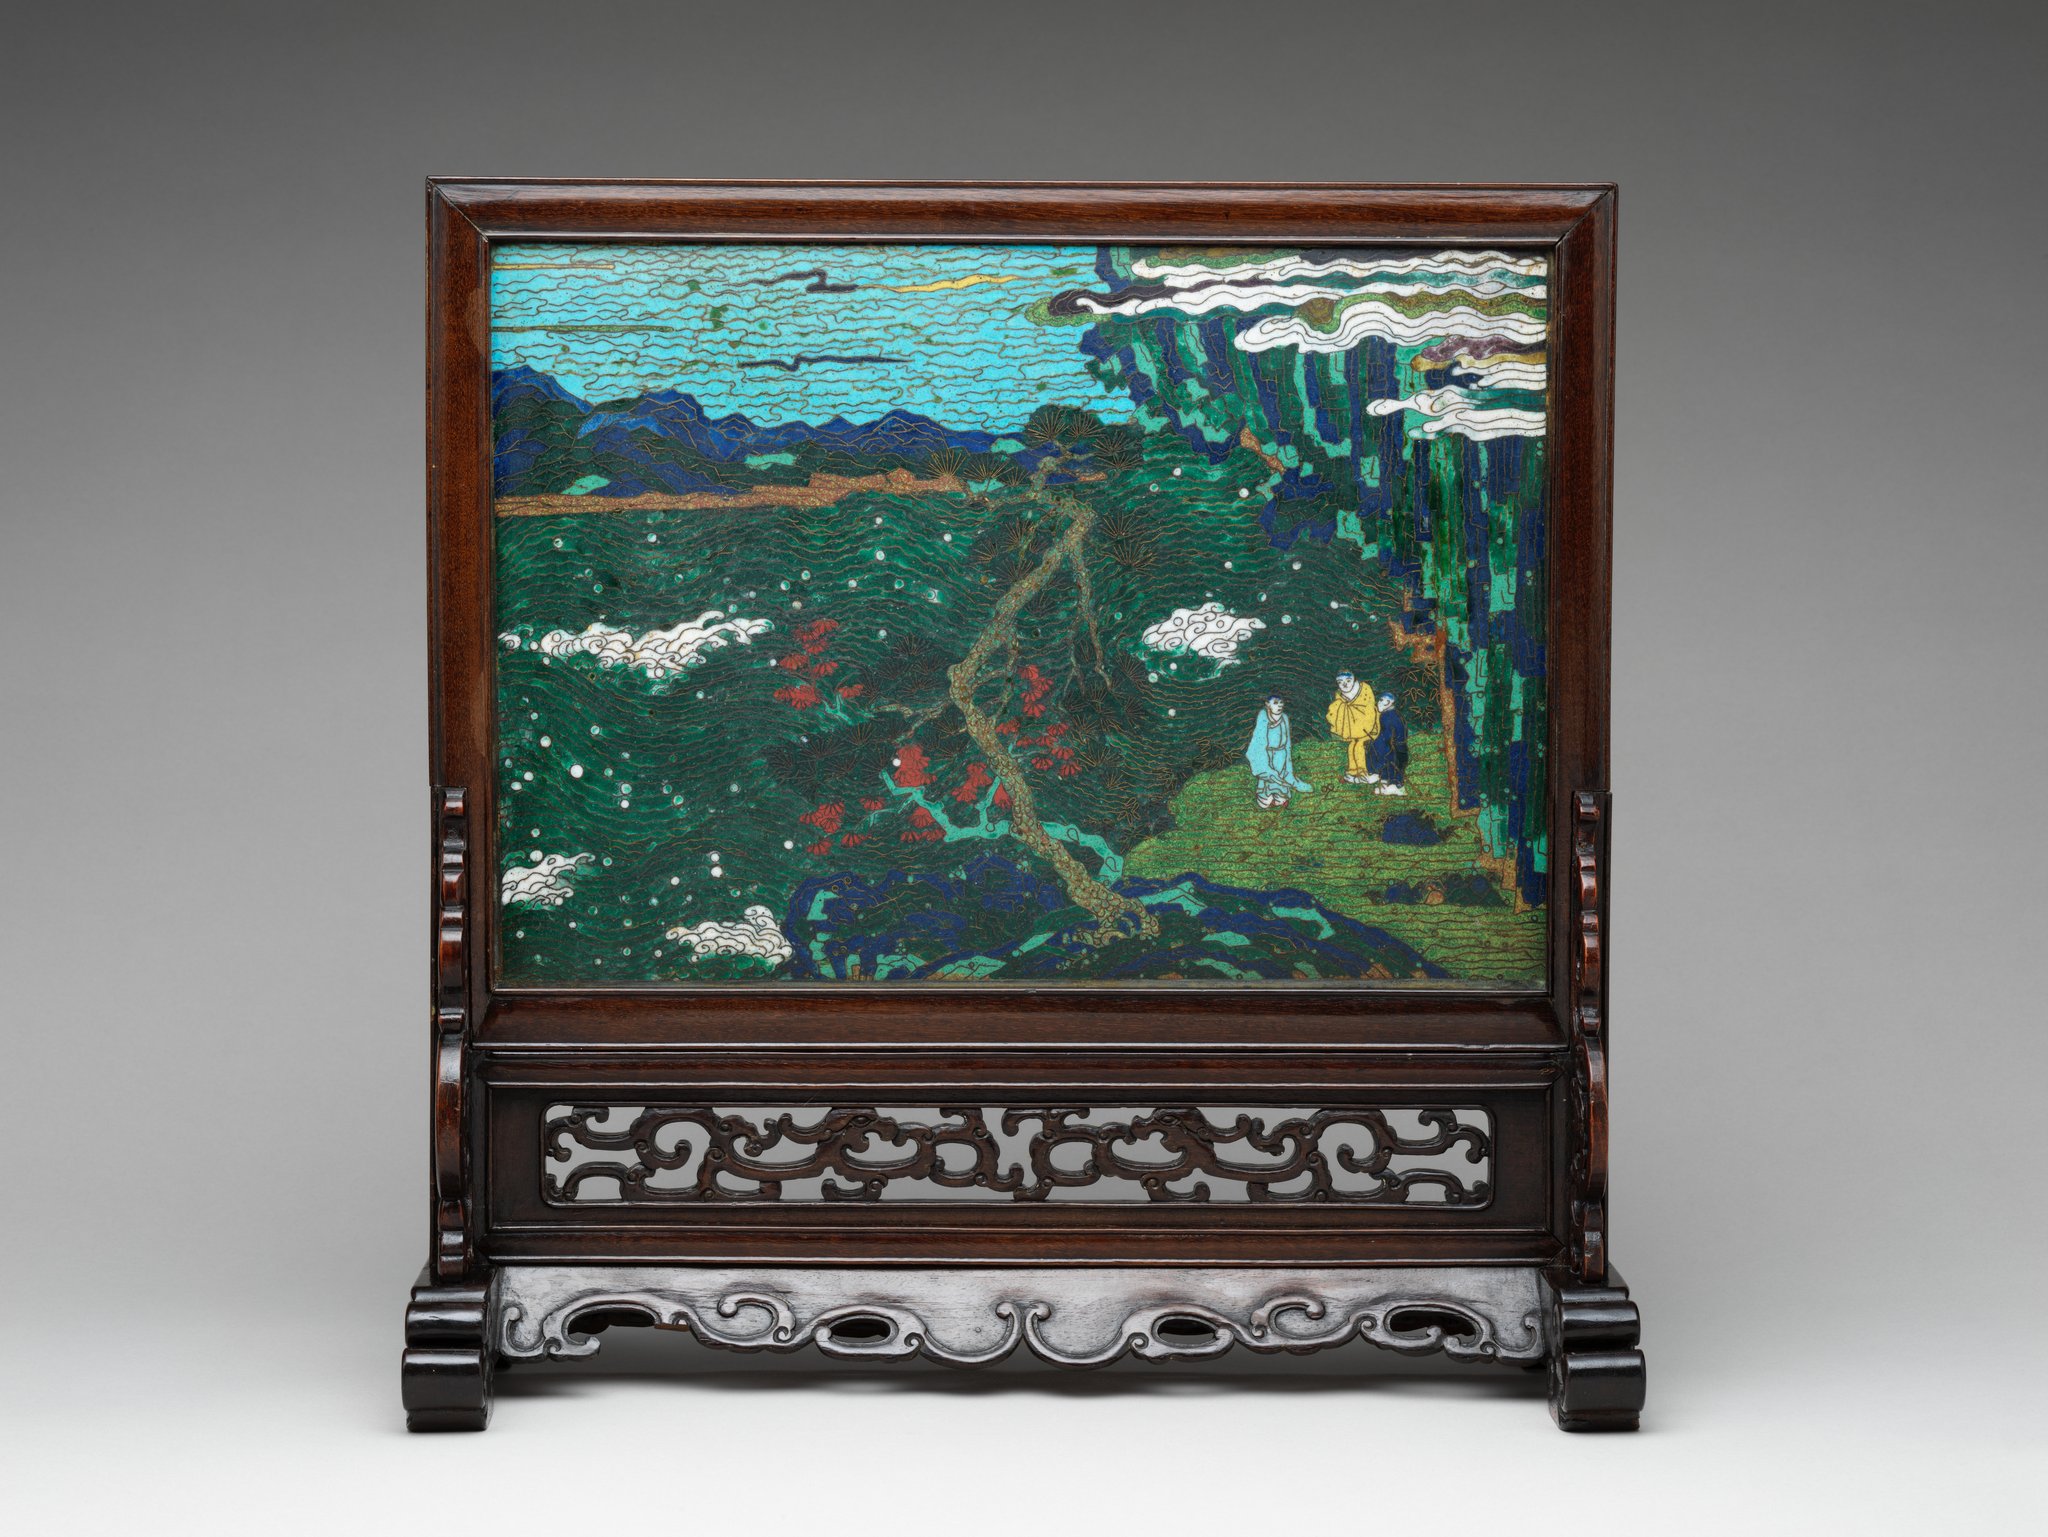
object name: table screen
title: Table screen with landscape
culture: chinese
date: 1451-1500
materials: enamel, wood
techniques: enamel